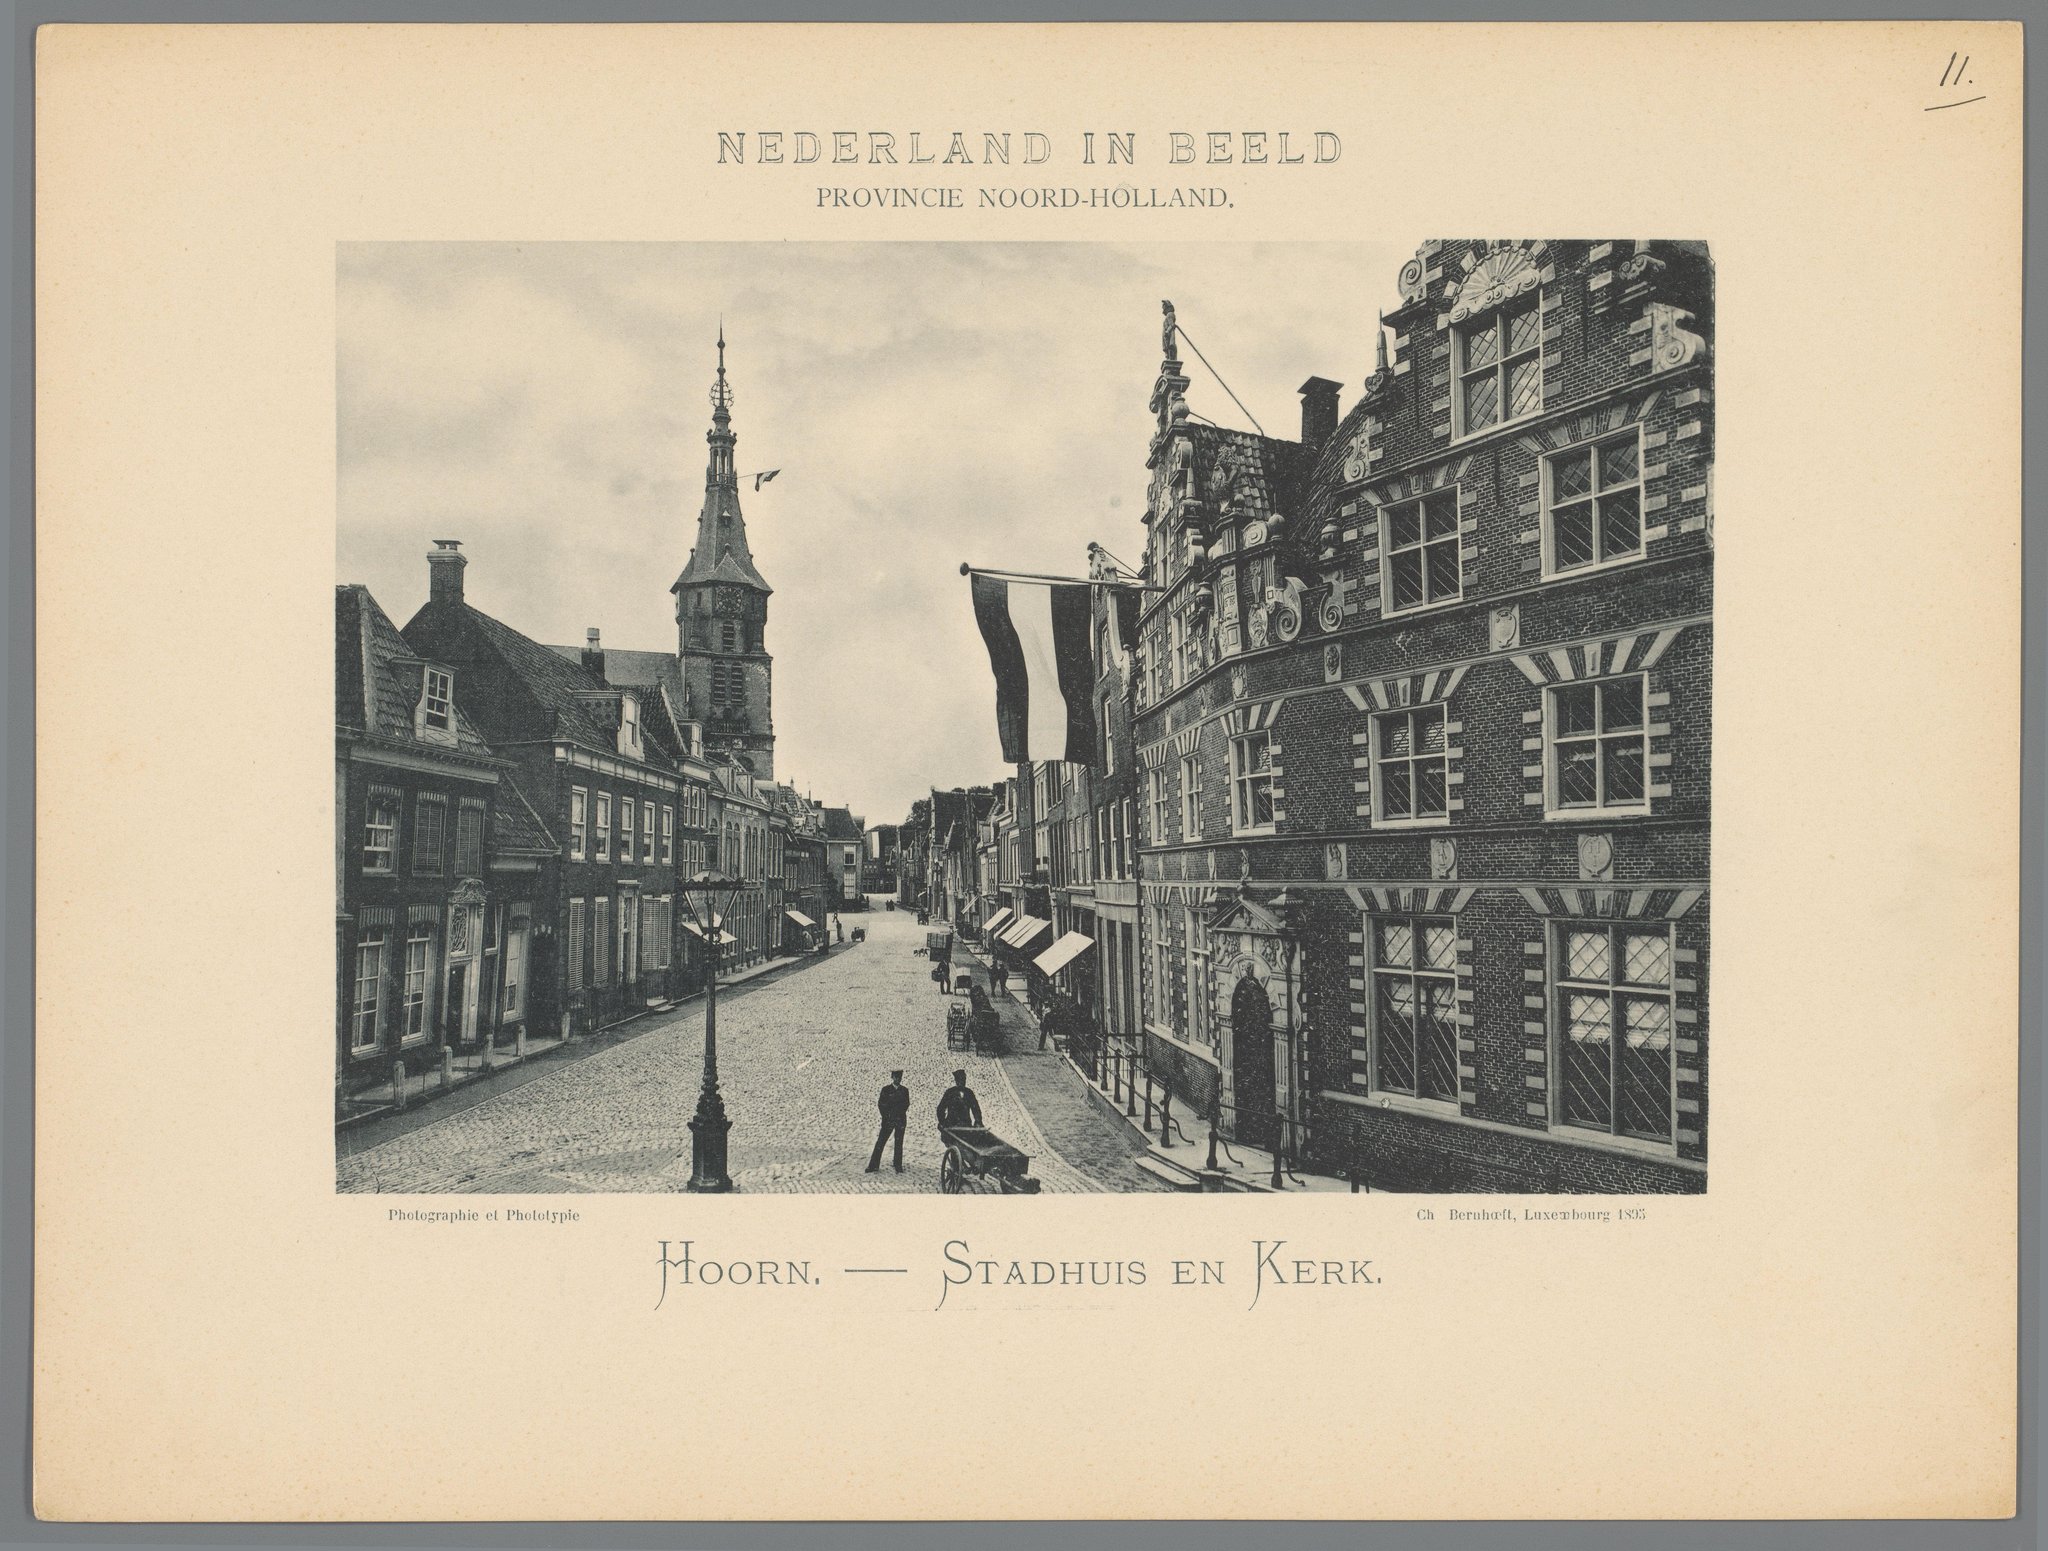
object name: photomechanical print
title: Hoorn. Stadhuis en kerk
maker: charles bernhoeft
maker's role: publisher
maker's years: 1859-1933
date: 1893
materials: cardboard, paper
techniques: photograph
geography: hoorn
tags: street, parts of church exterior and annexes: tower, flag, colours (as symbol of the state, etc.), hoorn (north holland)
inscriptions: number: ‘11.’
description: Deze prent maakt deel uit van een omslag met 43 lichtdrukken op 43 bladen.